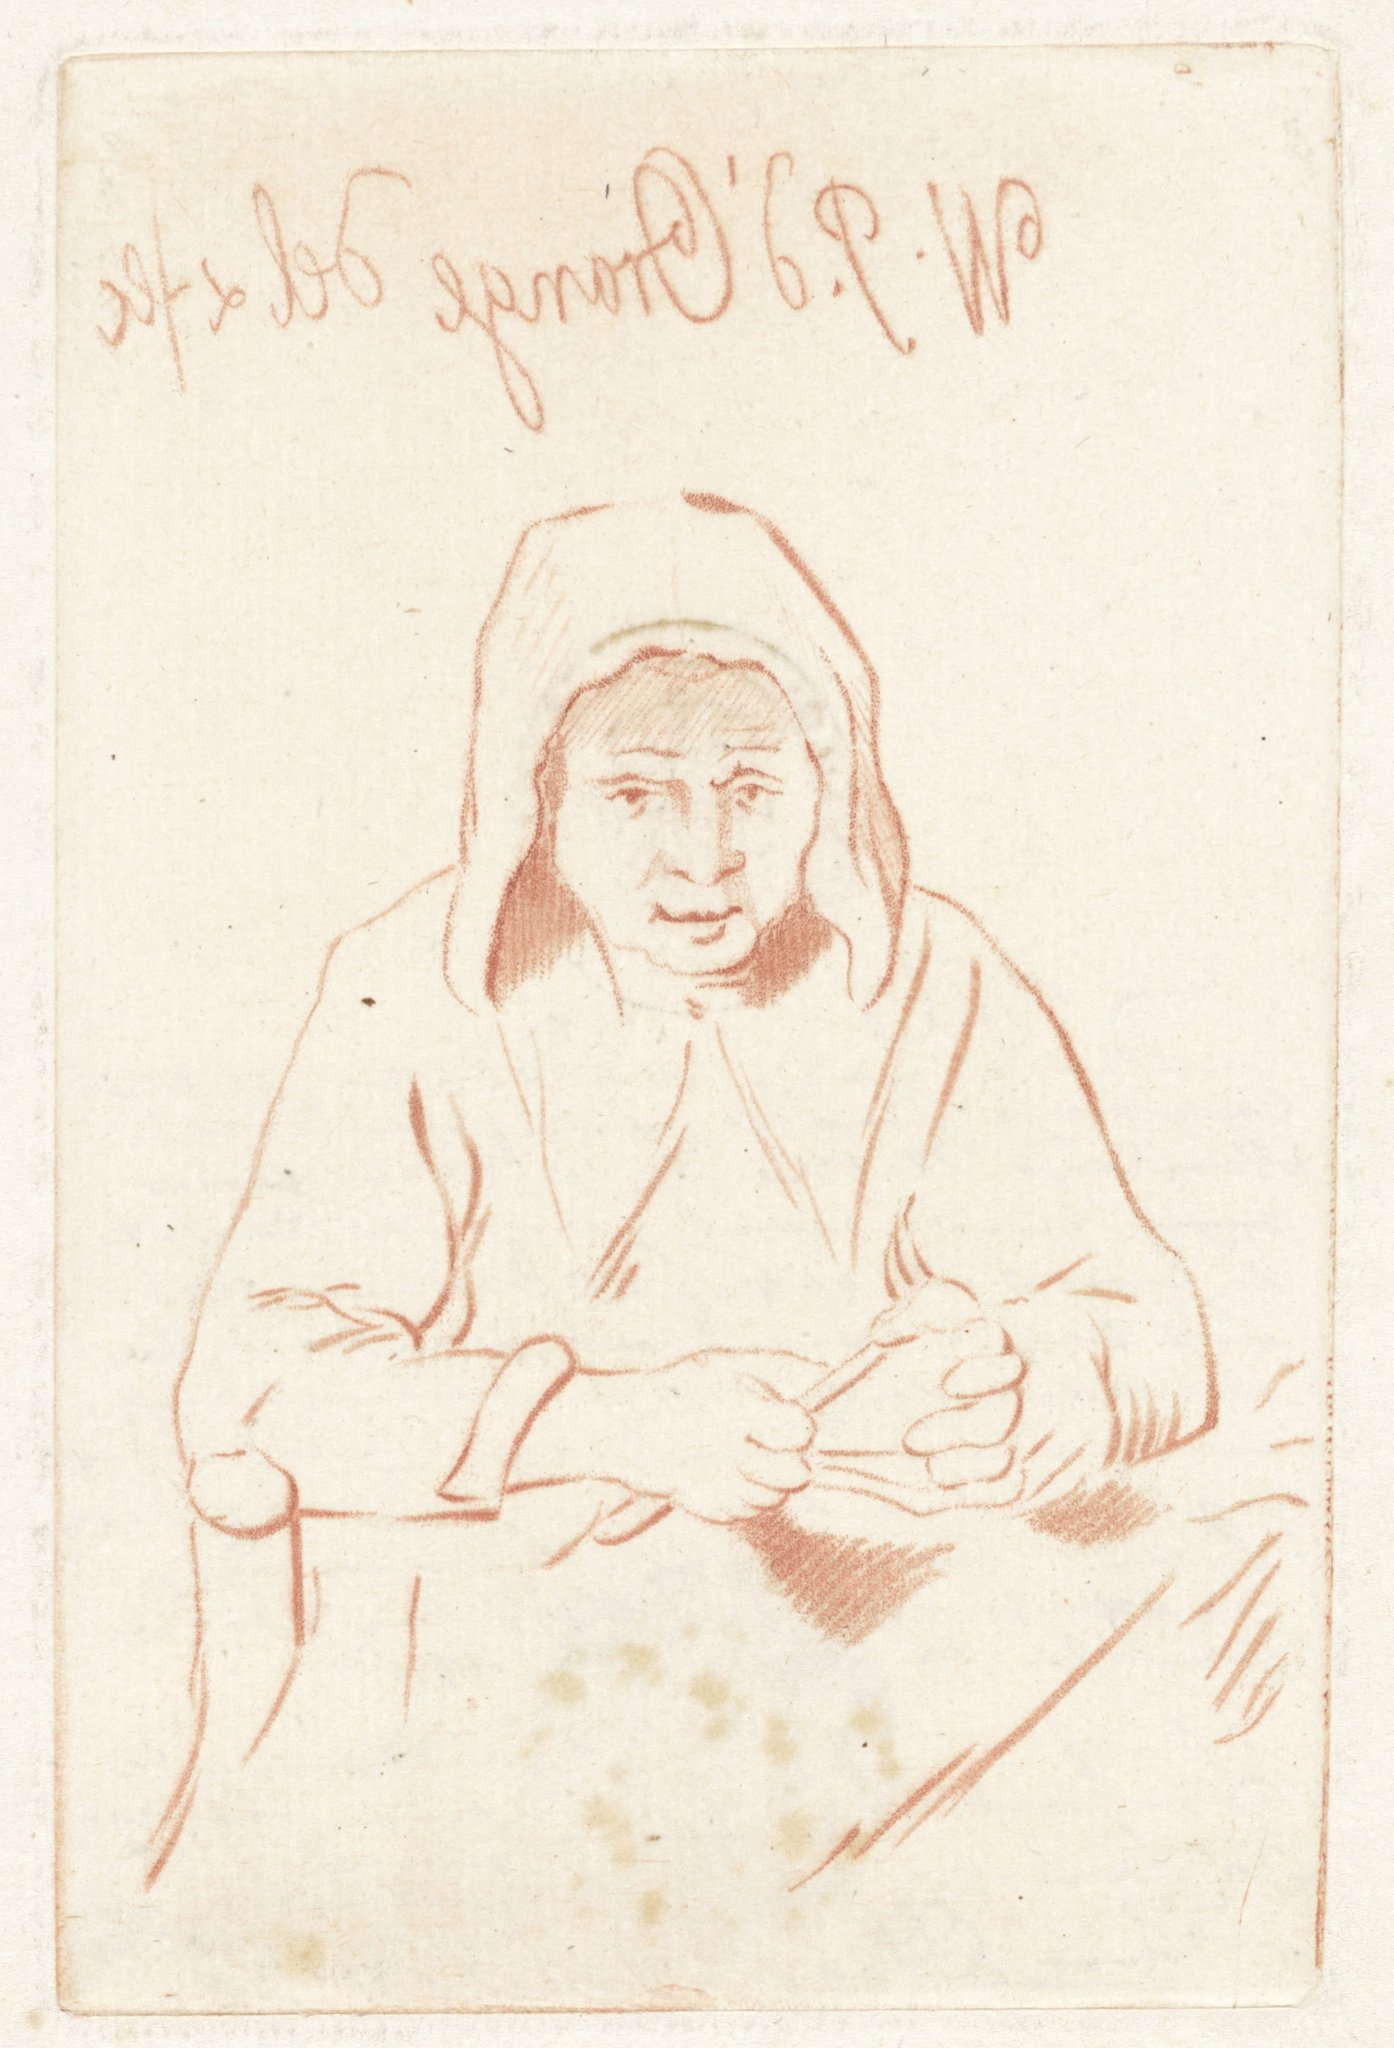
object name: print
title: Zittende oude vrouw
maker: william v (prince of orange)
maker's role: stadhouder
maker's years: 1748-1806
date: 1773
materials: ink, paper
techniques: aquatint, printmaking, pen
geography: the hague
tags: old woman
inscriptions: collector's mark: Lugt 240, inscription: ‘Den Prinse is gedankt op het origineele plaasje door zijne doorl: hoogheid...’